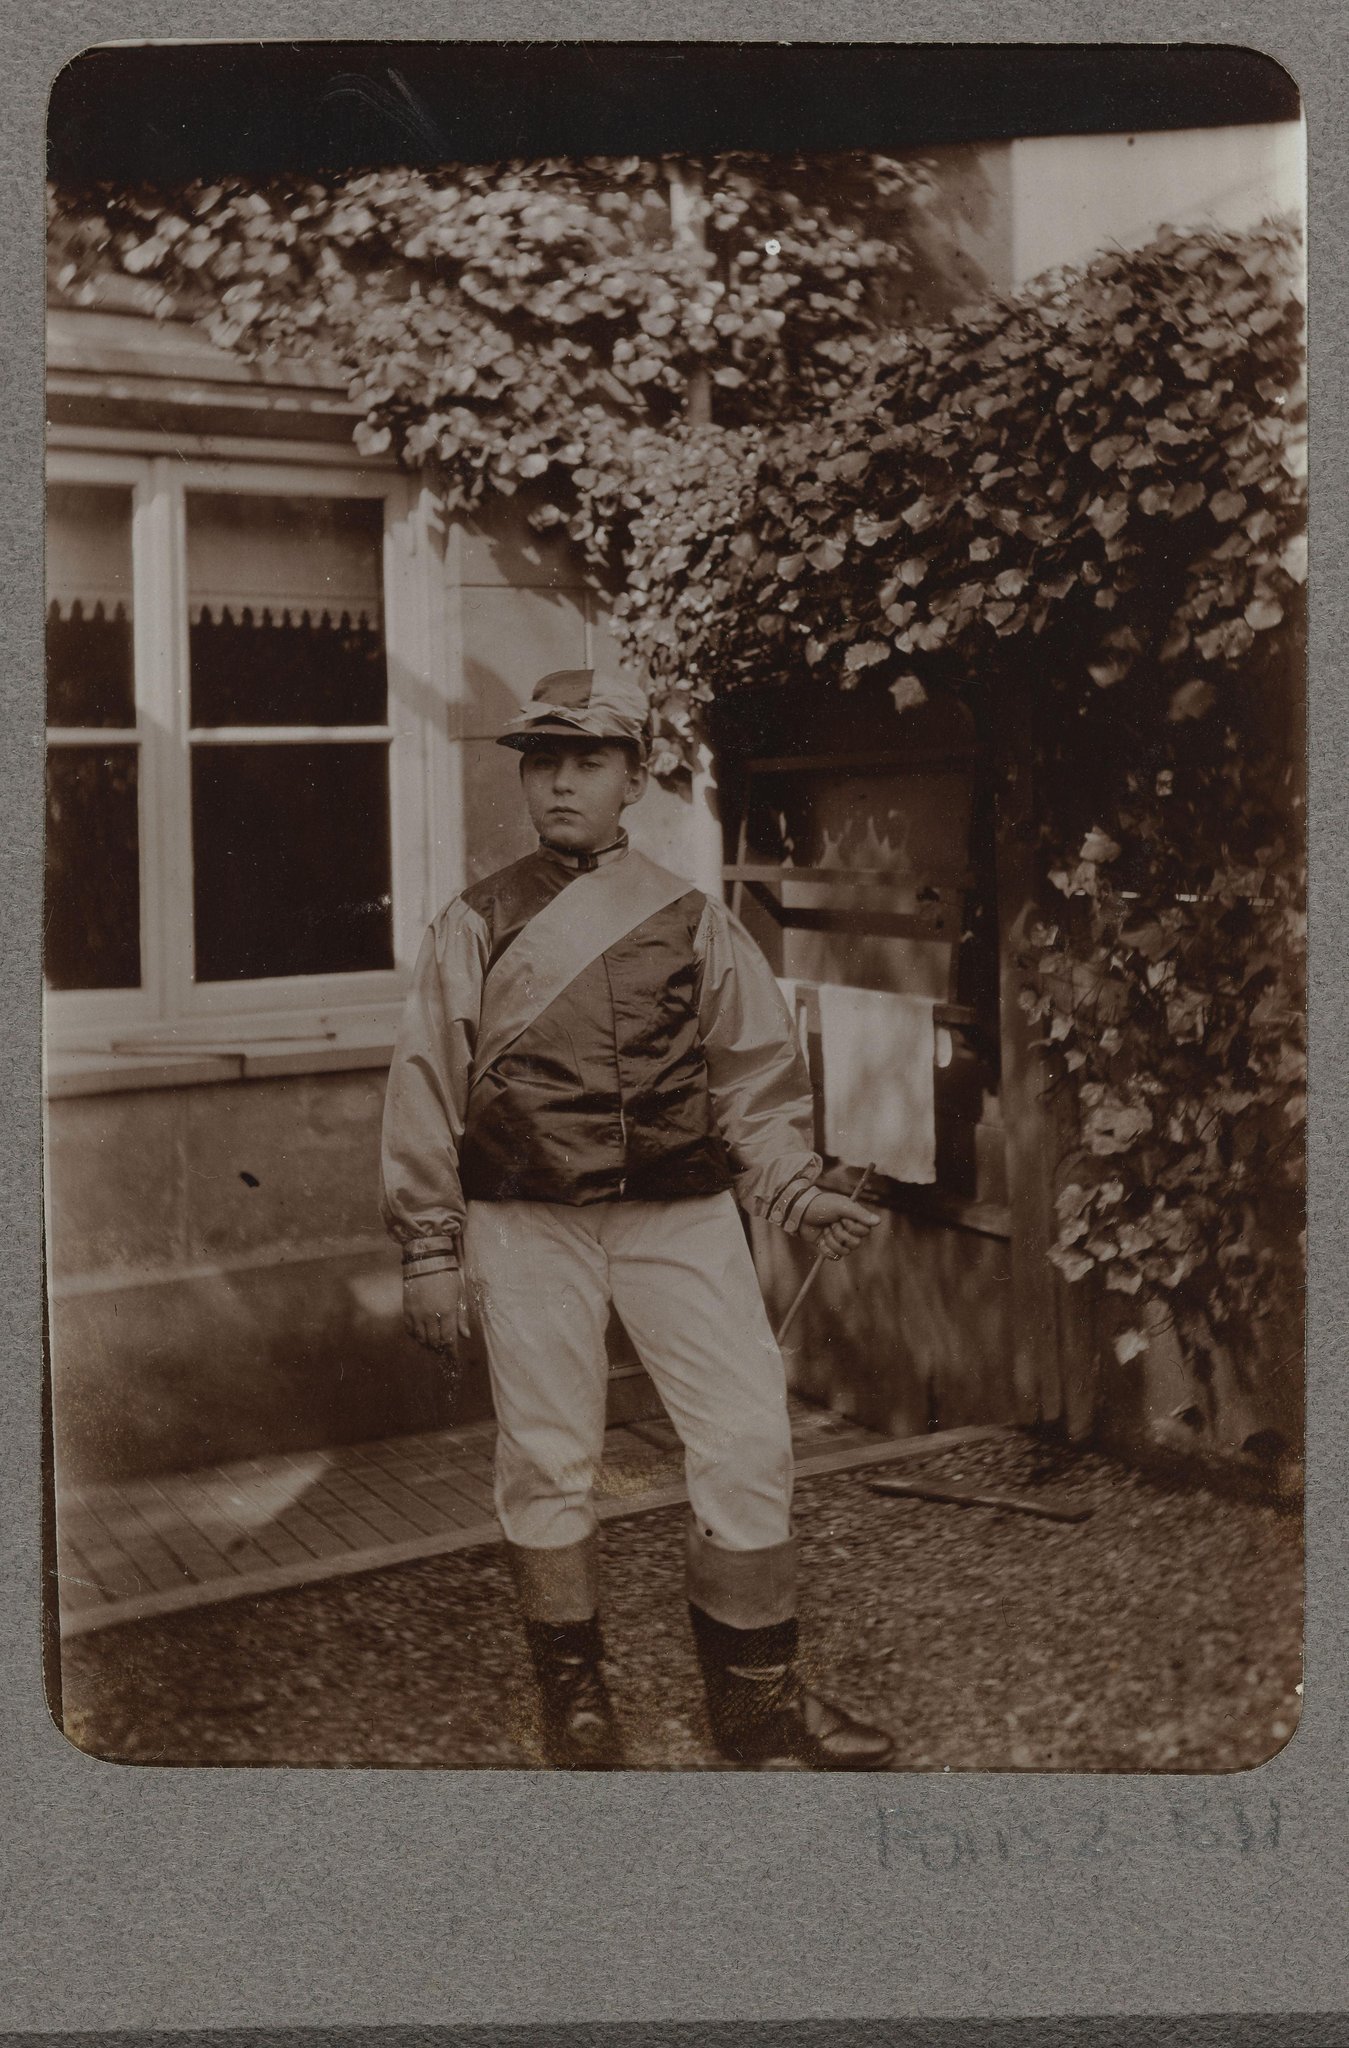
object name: photograph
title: Portret van een jongen in een rijkostuum, staande in een tuin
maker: christiaan otto roelofs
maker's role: fotograaf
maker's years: 1882-1970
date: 1900-1915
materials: photographic support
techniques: collodion silver print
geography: netherlands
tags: garden, historical persons